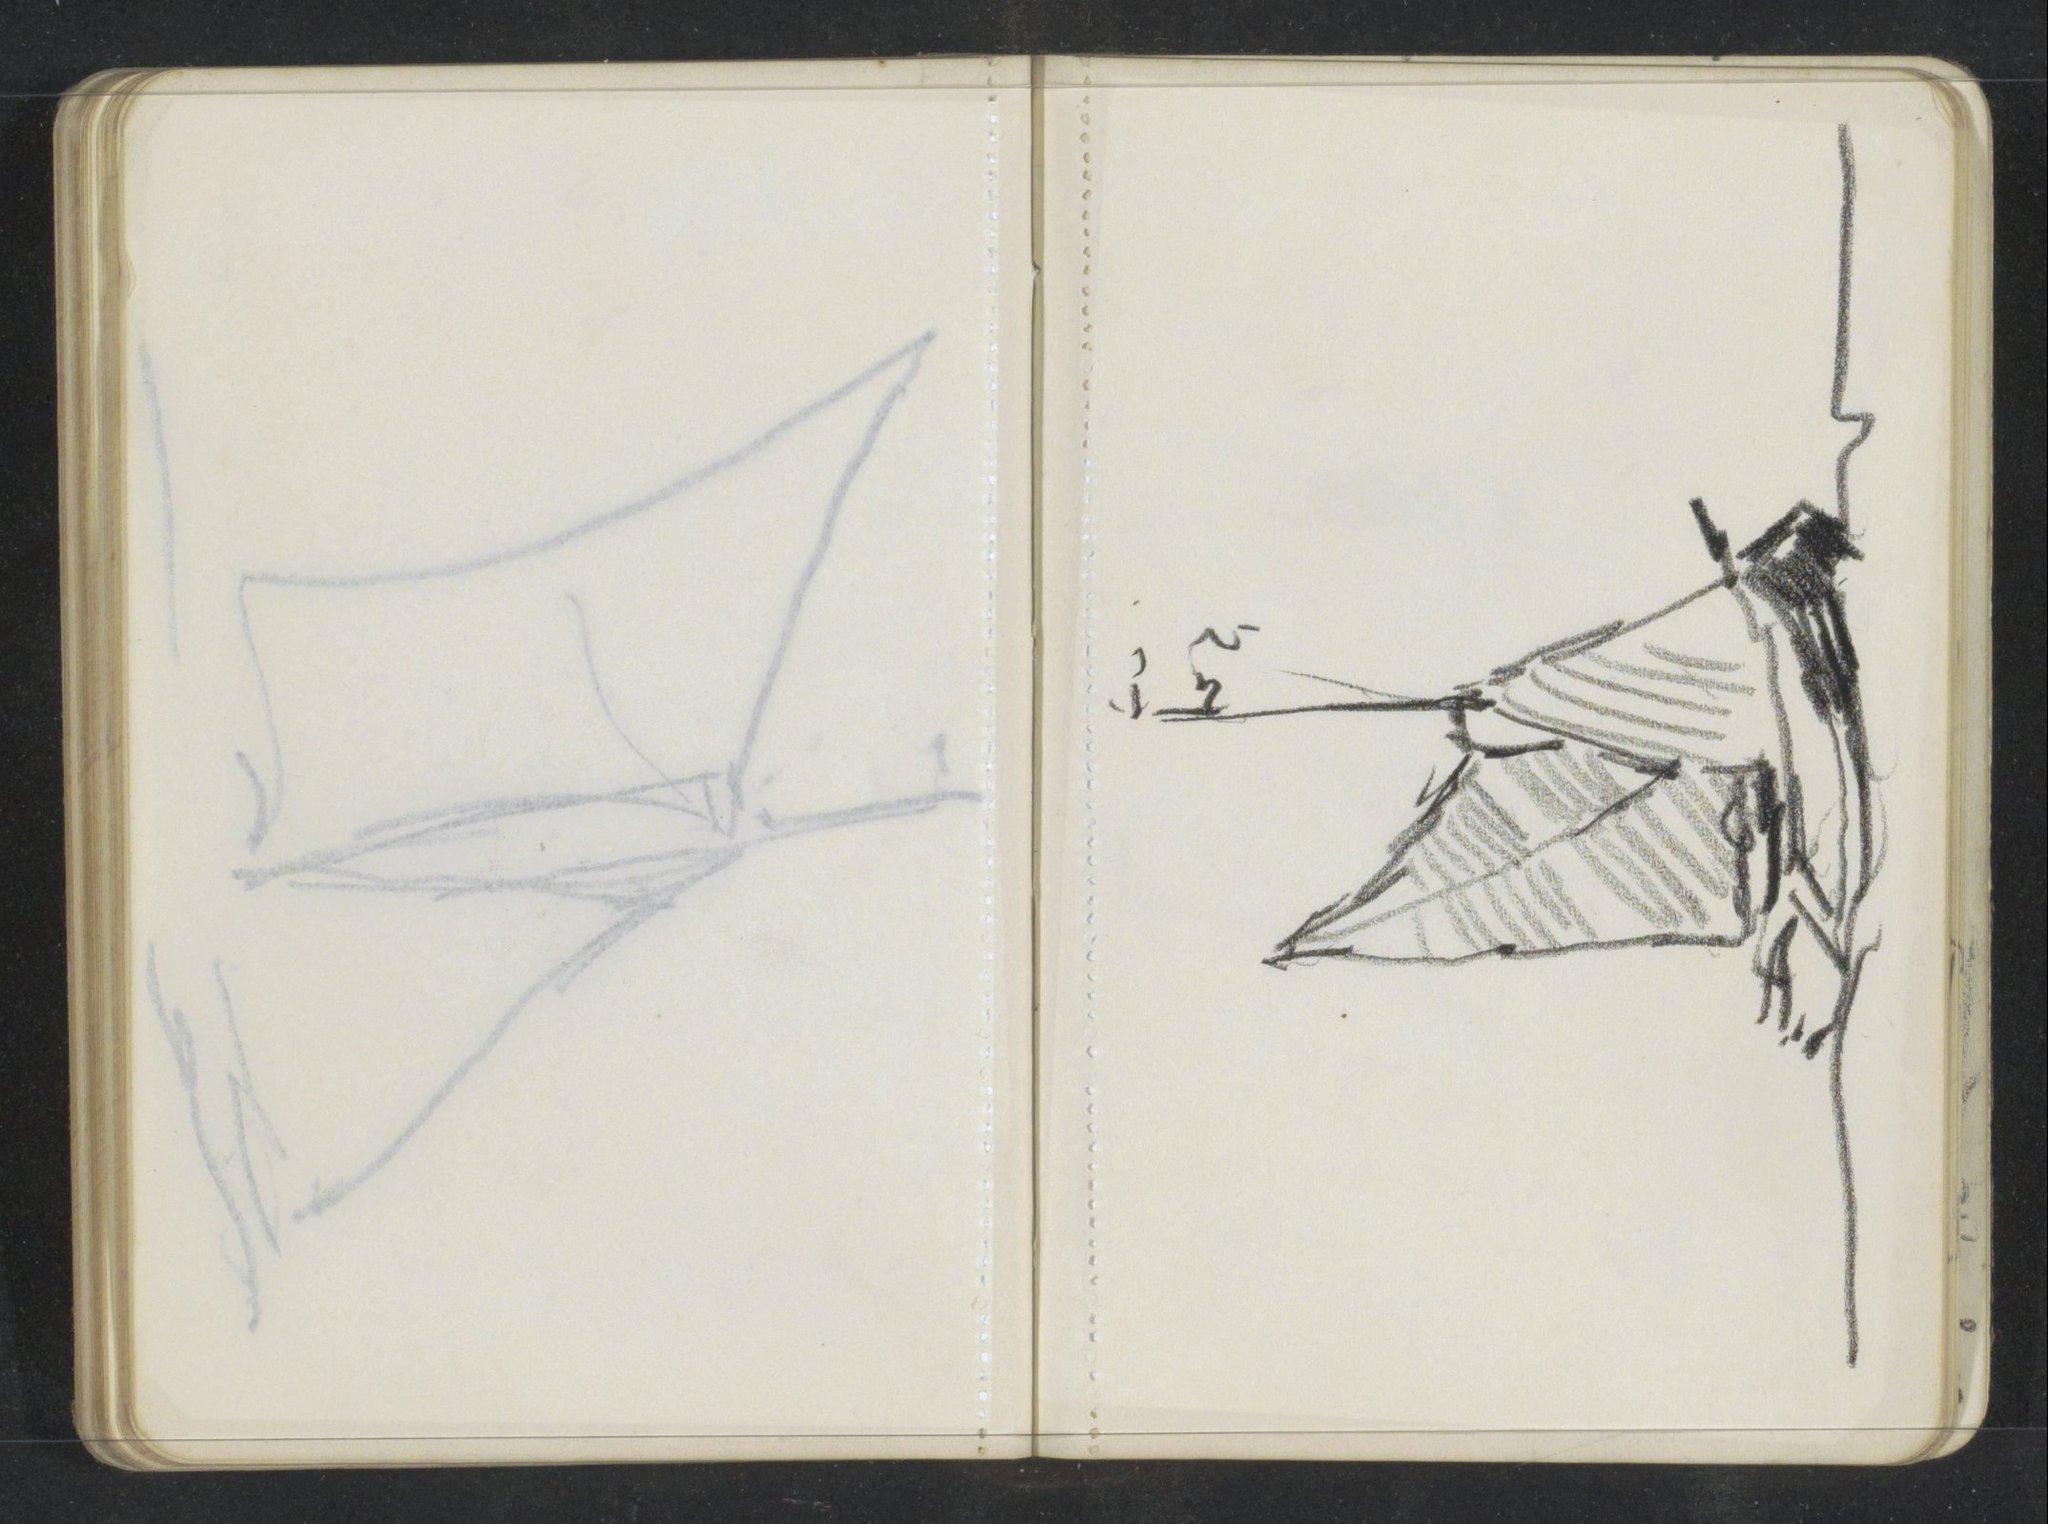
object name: sketchbook leaf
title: Zeilboot op het water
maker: alexander shilling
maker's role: draughtsman, print maker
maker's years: 1859-1937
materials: paper, pencil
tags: sailing-ship, sailing-boat, landscapes with waters, waterscapes, seascapes (in the temperate zone)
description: Blad 56 recto uit een schetsboek met 91 bladen.